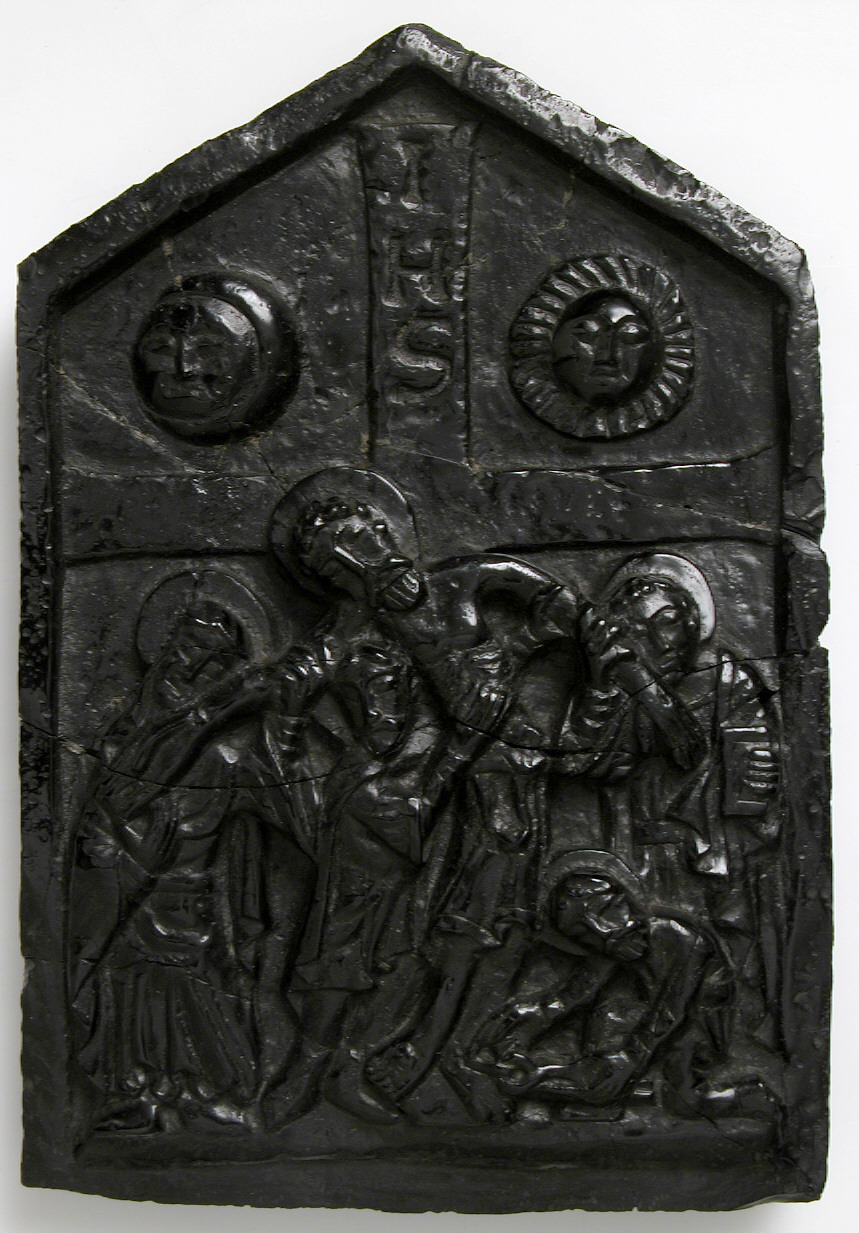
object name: pax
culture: spanish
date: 1101-1200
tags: christ,crucifixion